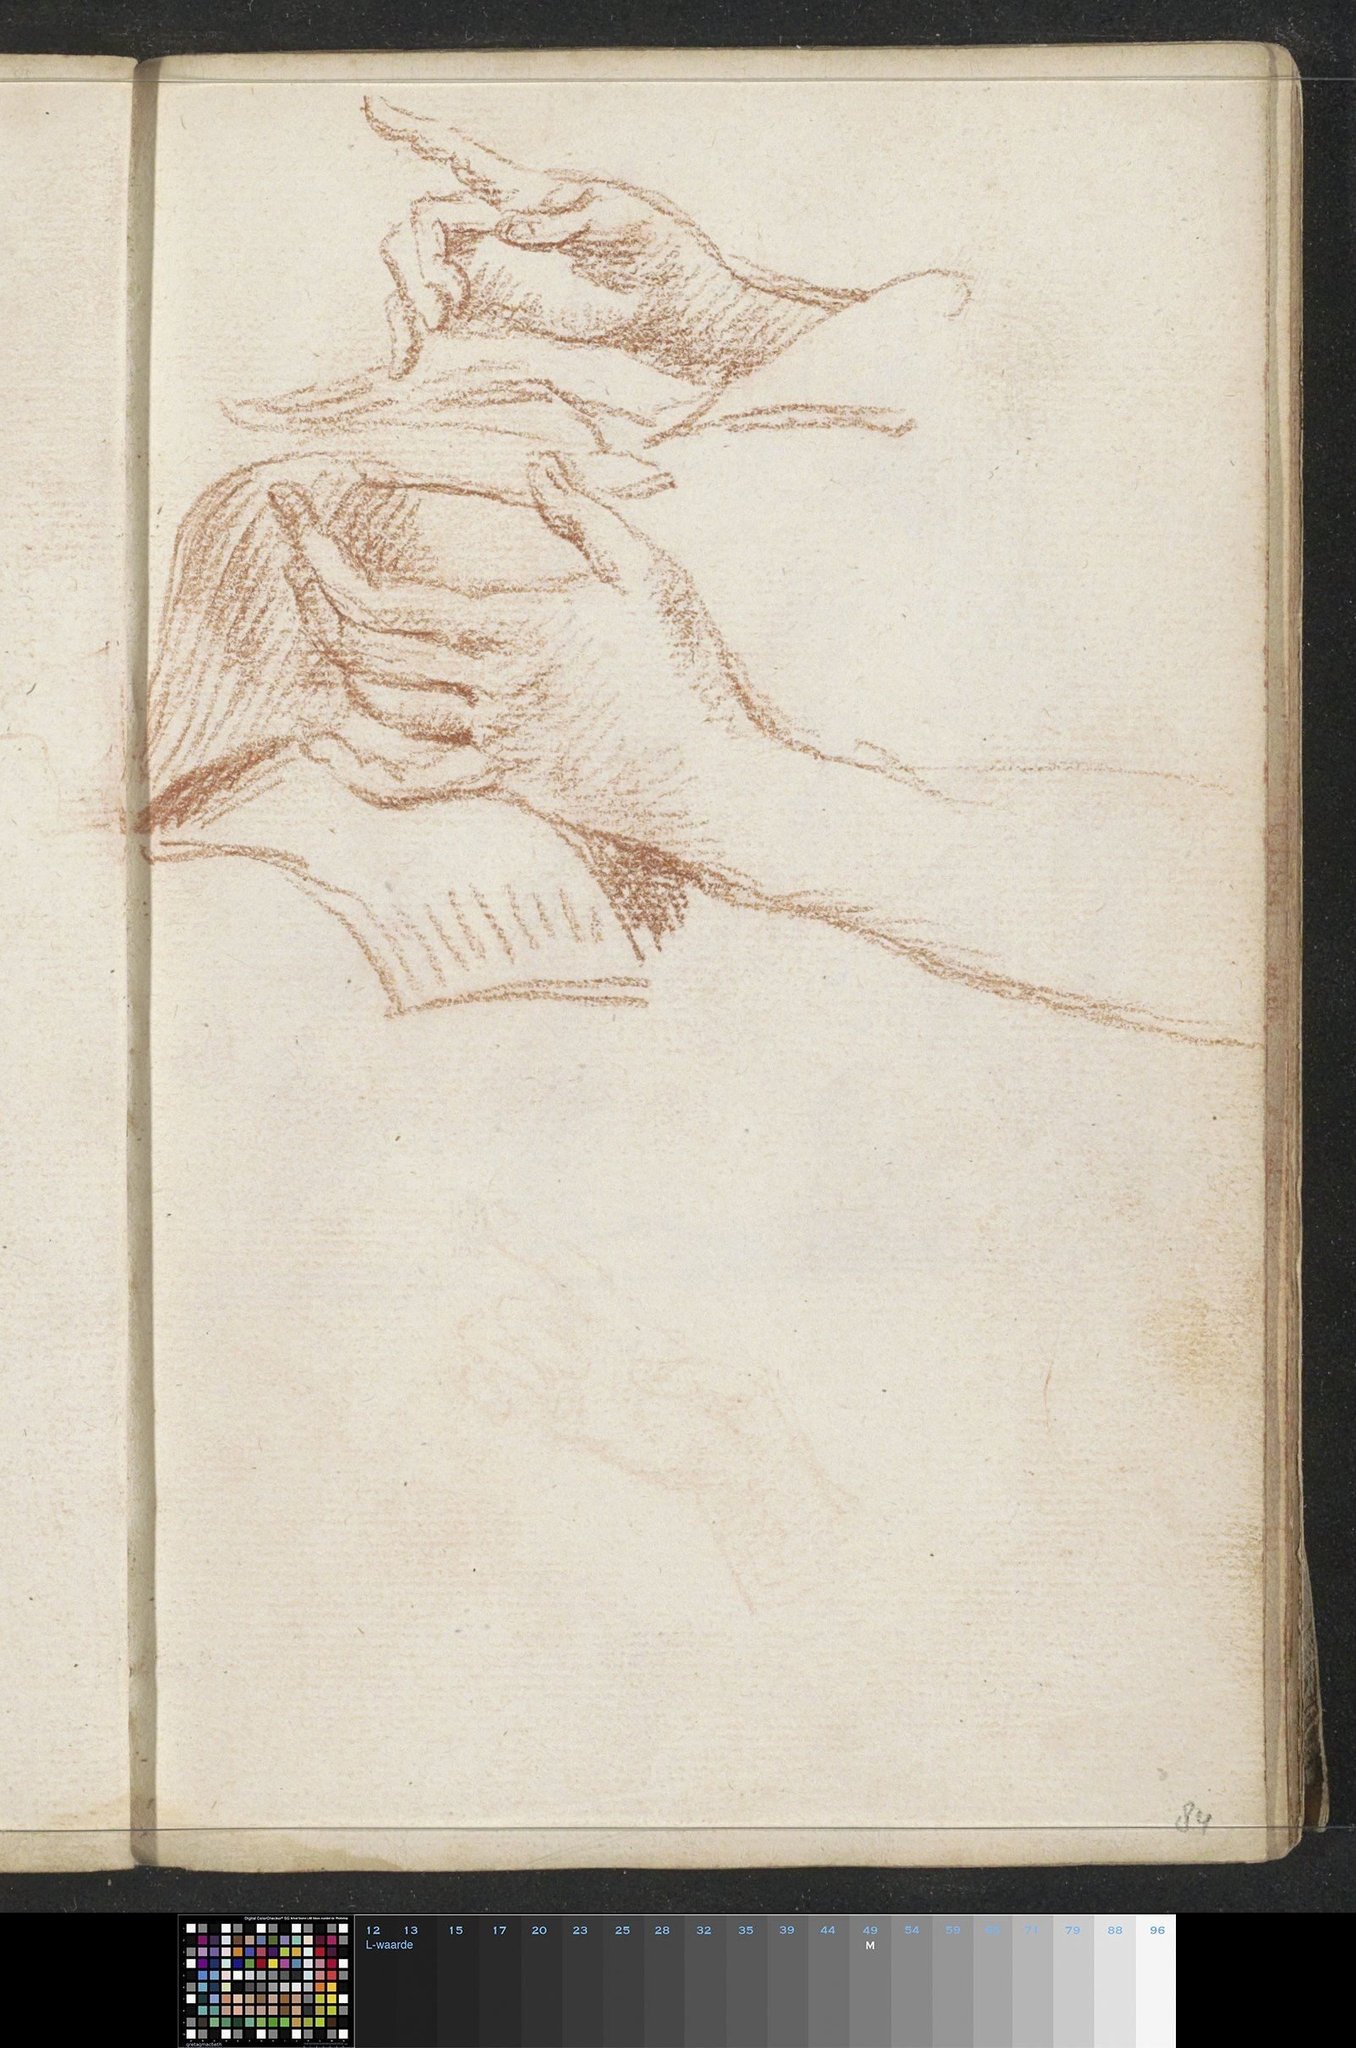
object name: sketchbook leaf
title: Twee handen die door boeken bladeren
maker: petrus johannes van reysschoot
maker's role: draughtsman, print maker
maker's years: 1702-1772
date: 1710-1772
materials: chalk, paper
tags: hand, book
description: Blad 84 recto uit een schetsboek met 105 bladen.